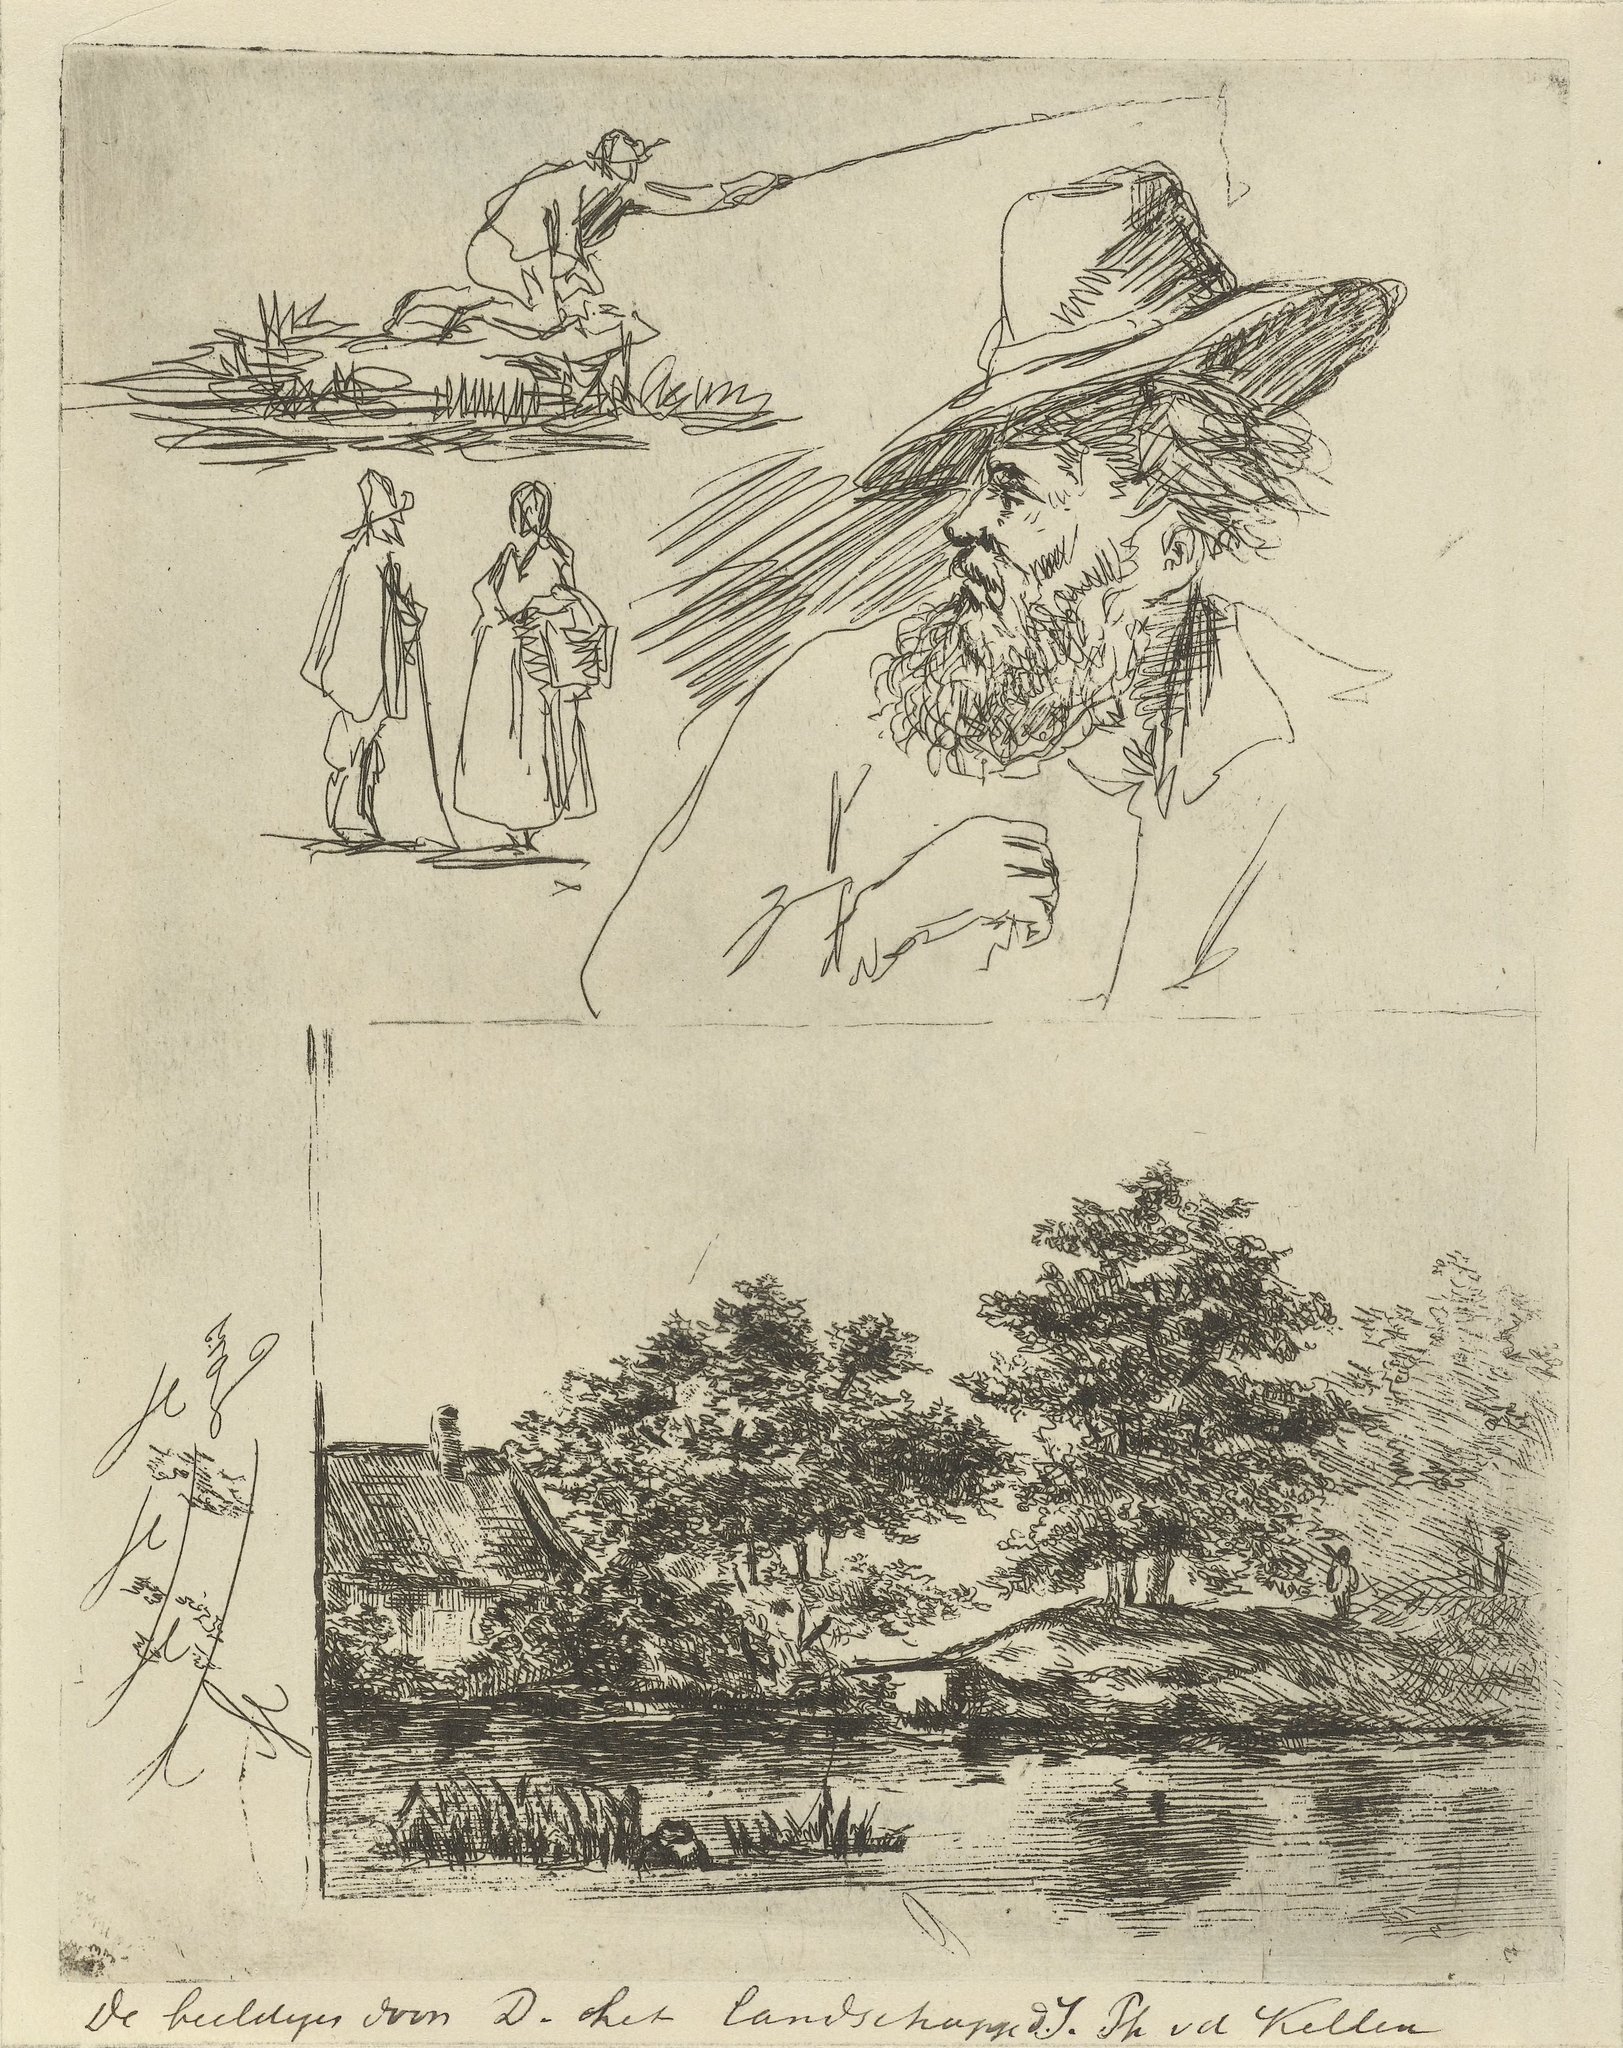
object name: print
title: Studieblad met vier figuren en een landschap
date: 1841-1878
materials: paper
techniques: drypoint, etching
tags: landscapes, river, fisherman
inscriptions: inscription: ‘De beeldjes door D. het landschapje d J. Ph vd Kellen’, collector's mark: Lugt 2228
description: Studieblad met links boven drie figuren waarvan er een aan het vissen is. Daarnaast het hoofd van een oudere man met baard en hoed en rechts onderaan een landschap met een rivier, bomen en een boerderij.